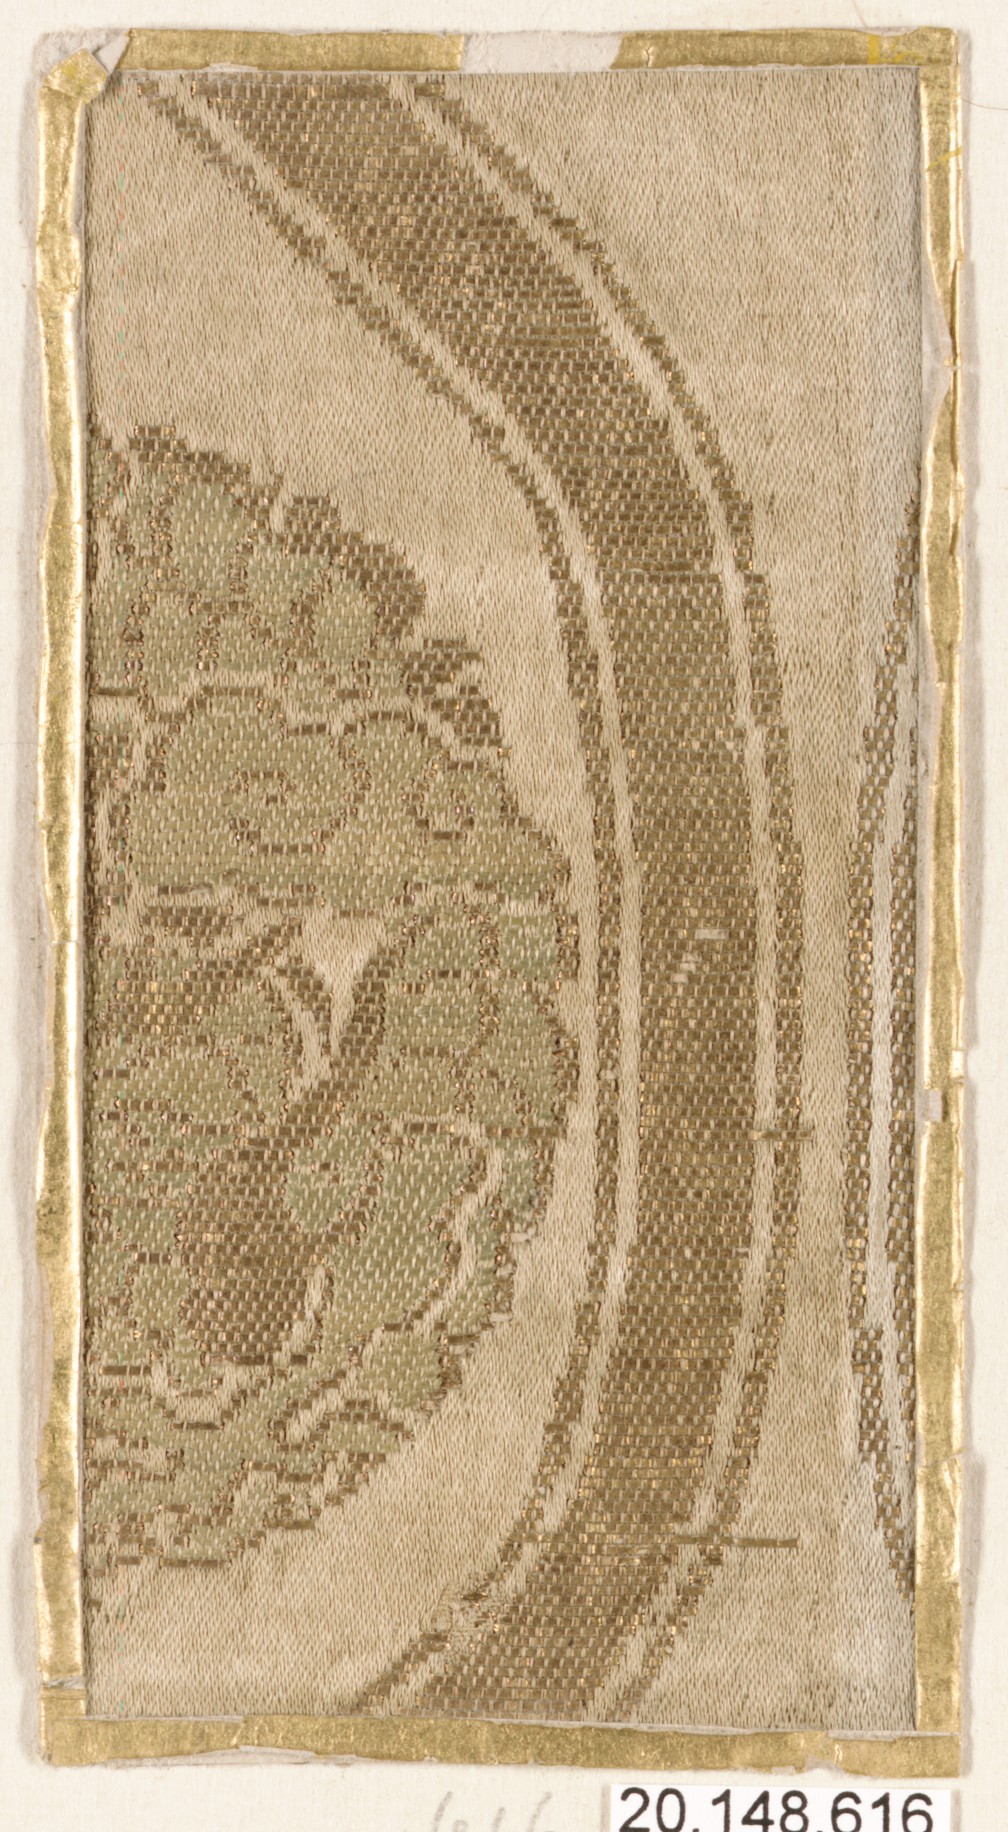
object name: piece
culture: japanese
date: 1601-1700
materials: silk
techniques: compound weave